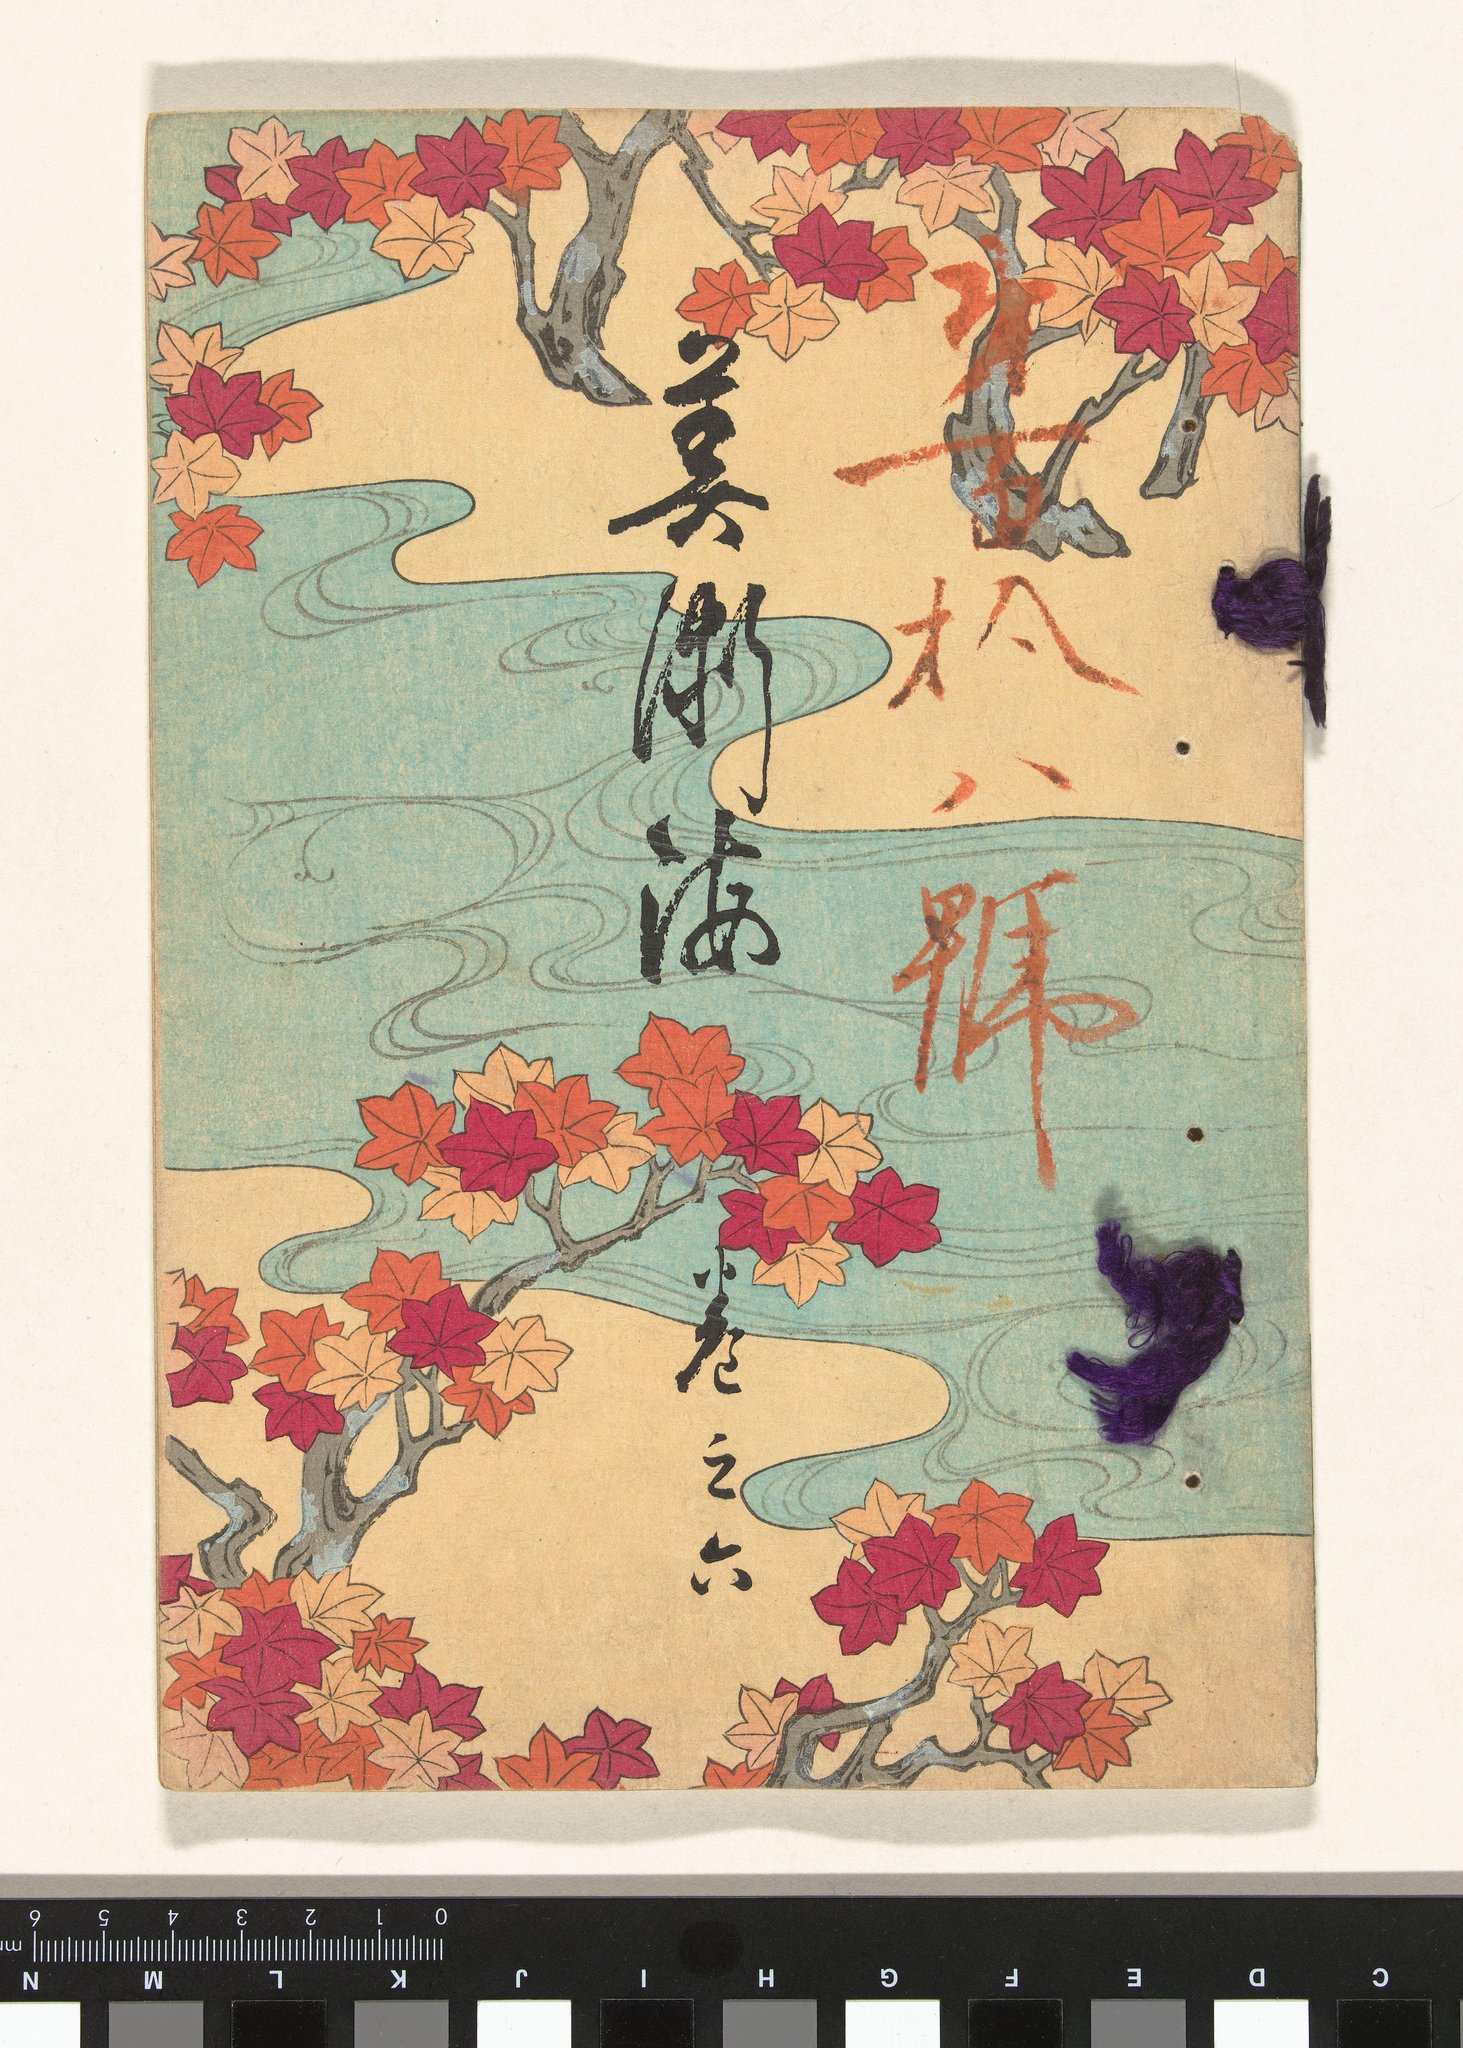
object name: book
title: Bijutsukai - kan no roku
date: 1896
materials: paper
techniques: woodcut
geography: kyoto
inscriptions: date